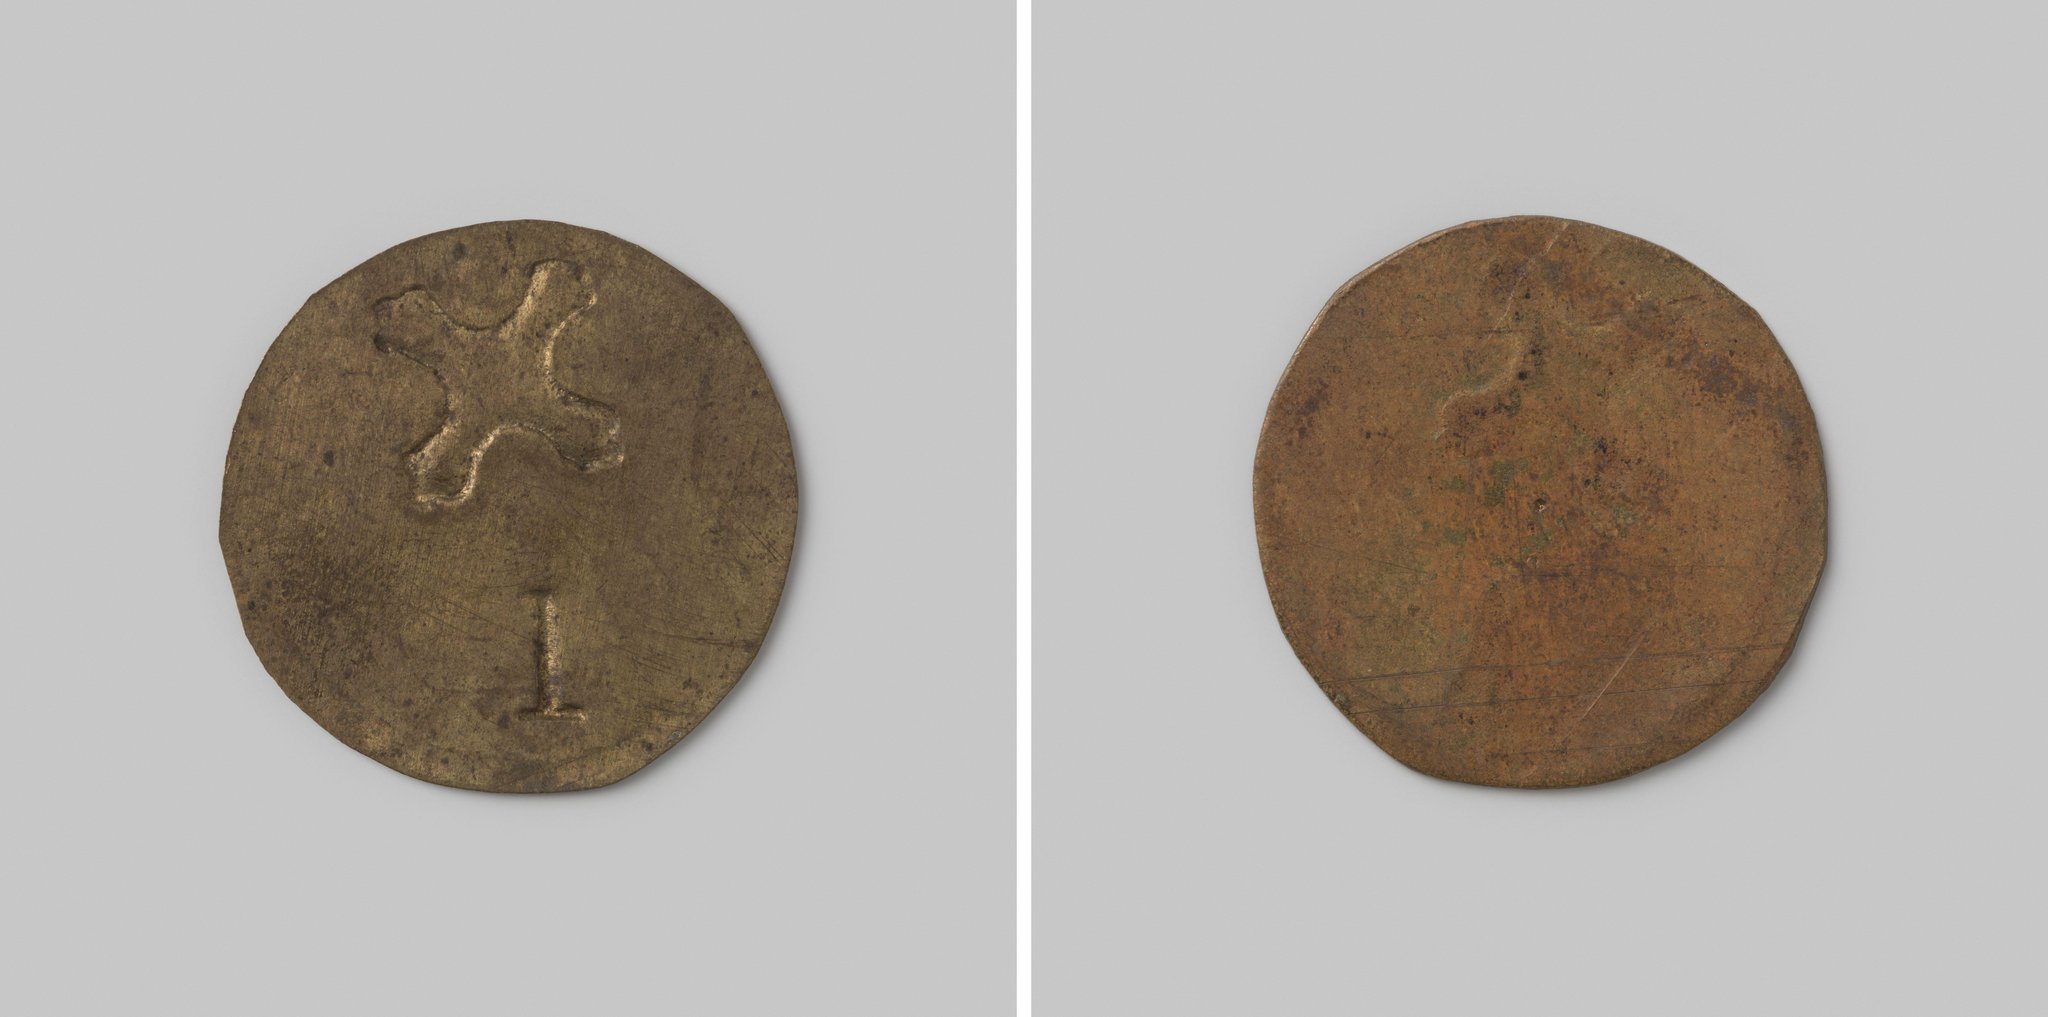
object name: monetary token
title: Betaalpenning van een cent van de Coöperatieve Winkelvereeniging De Volharding te Veenendaal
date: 1875-1900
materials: brass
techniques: printing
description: Rond messing plaatje met instempelingen (andreaskruis) / 1